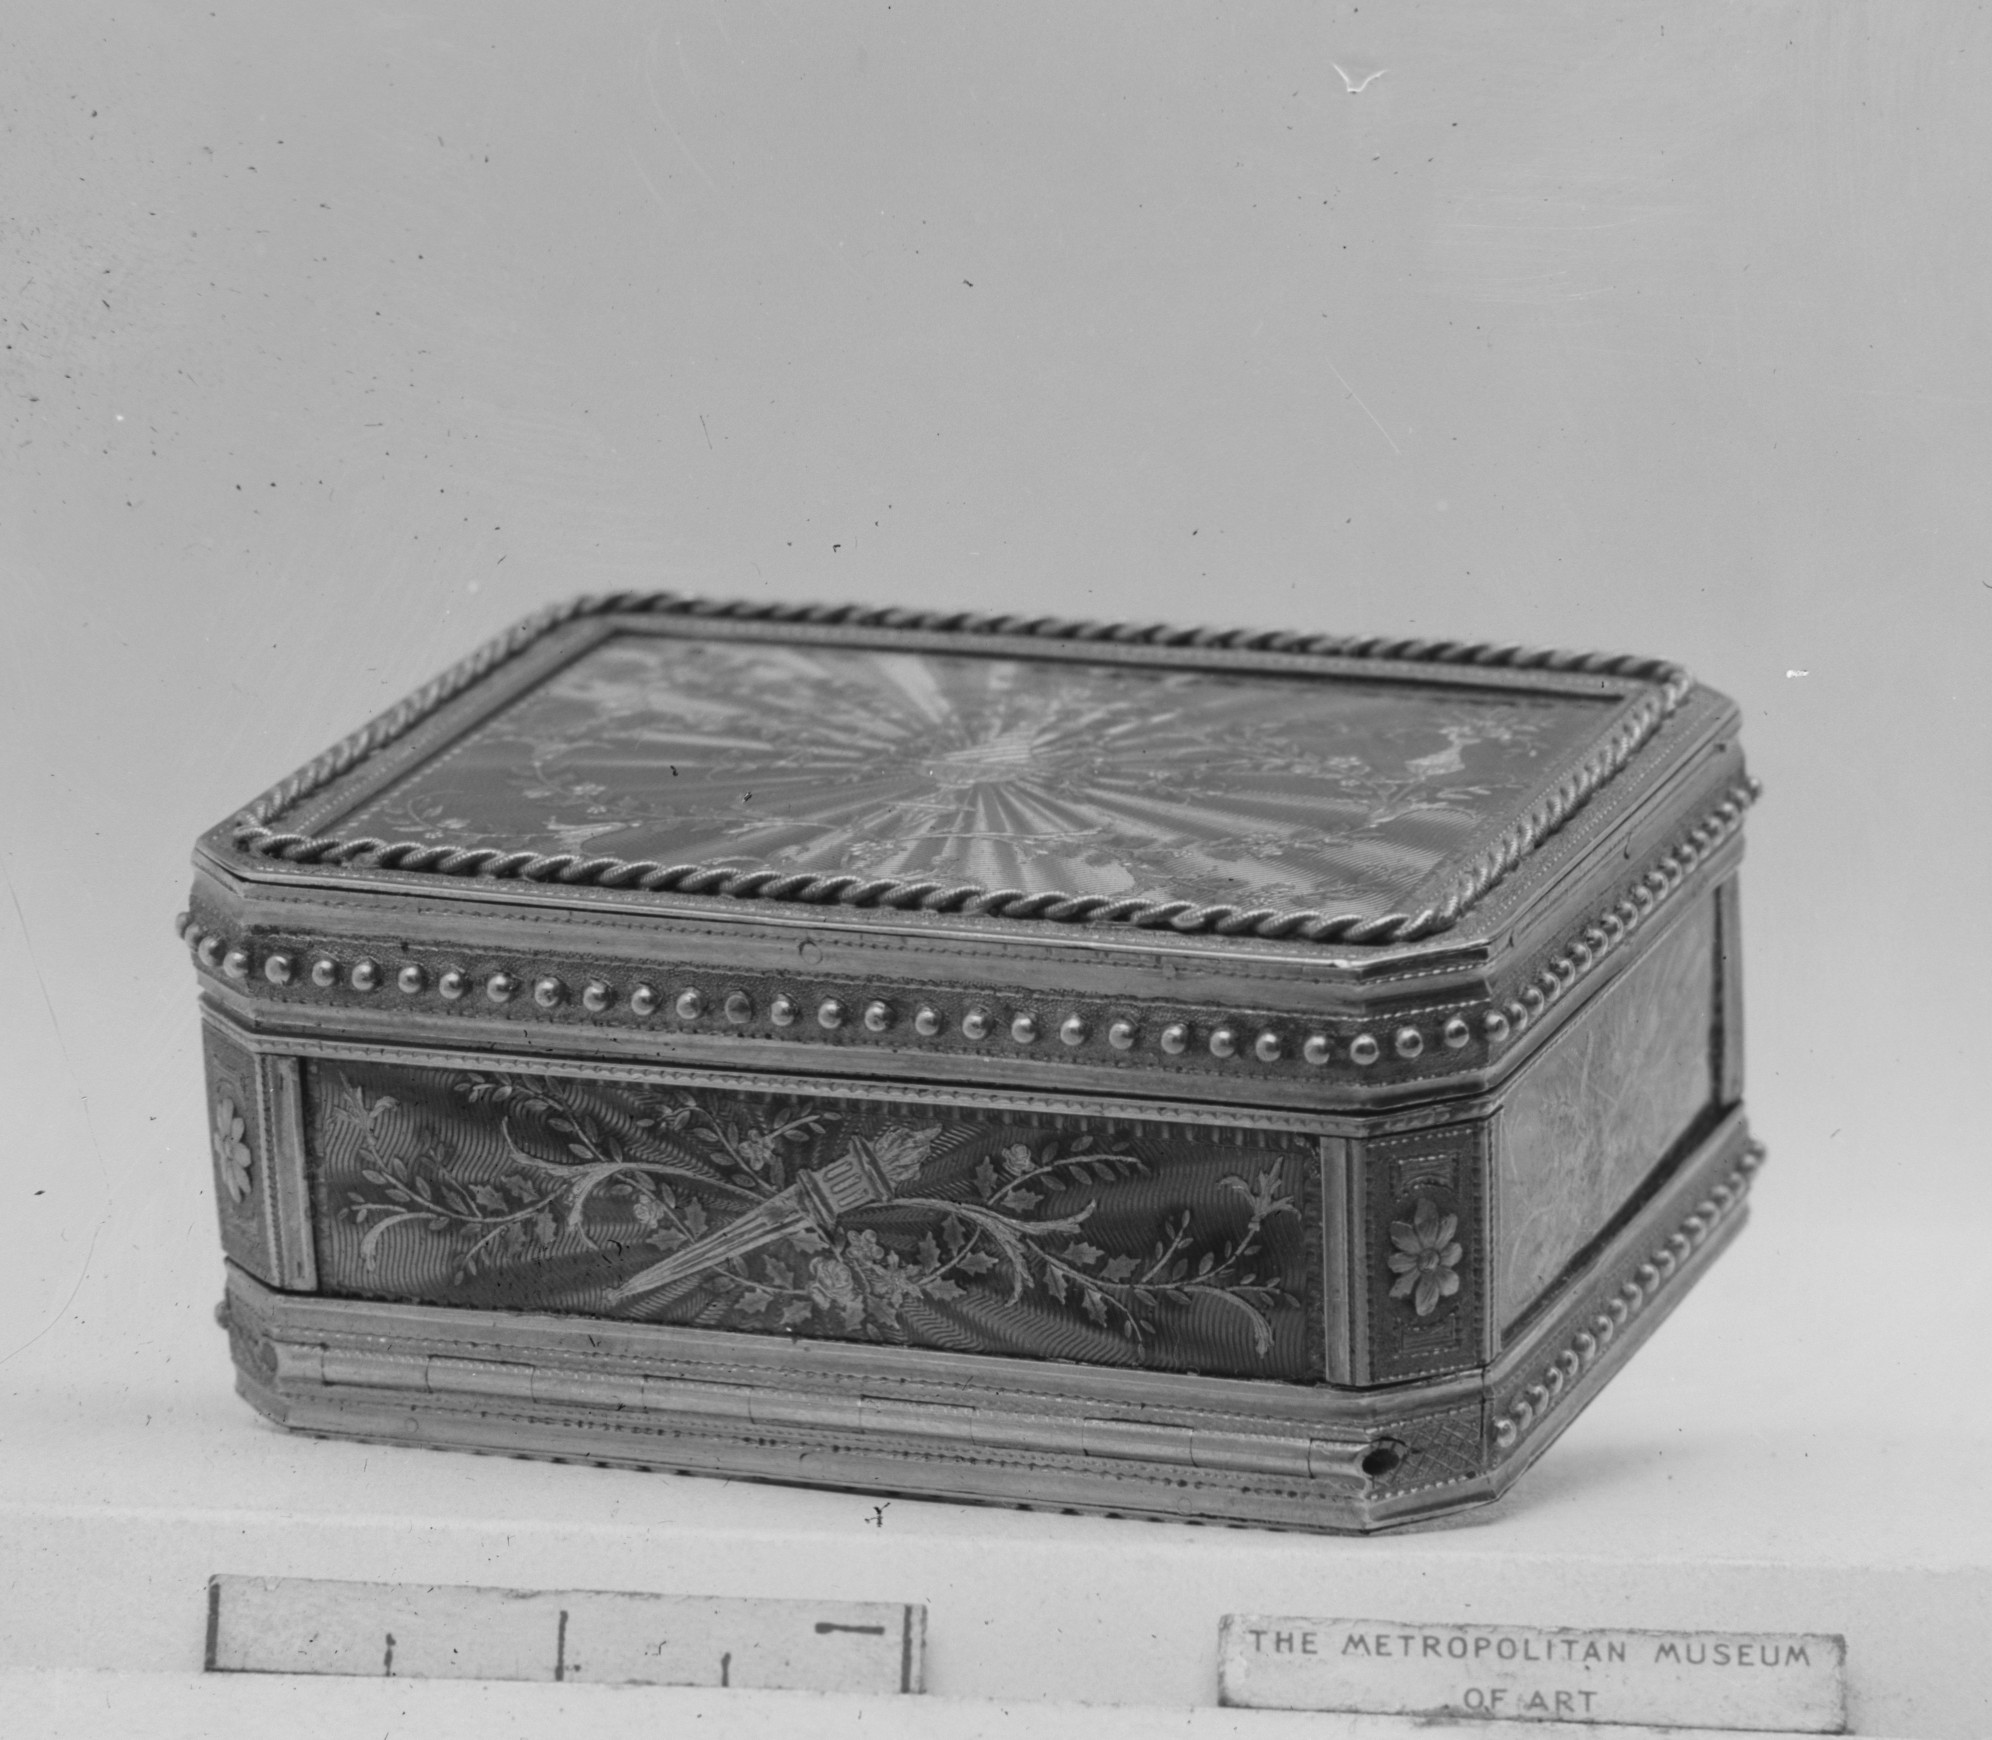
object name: patch box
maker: jean nicolas pique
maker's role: maker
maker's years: 1780-1793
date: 1783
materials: enamel, gold, ivory